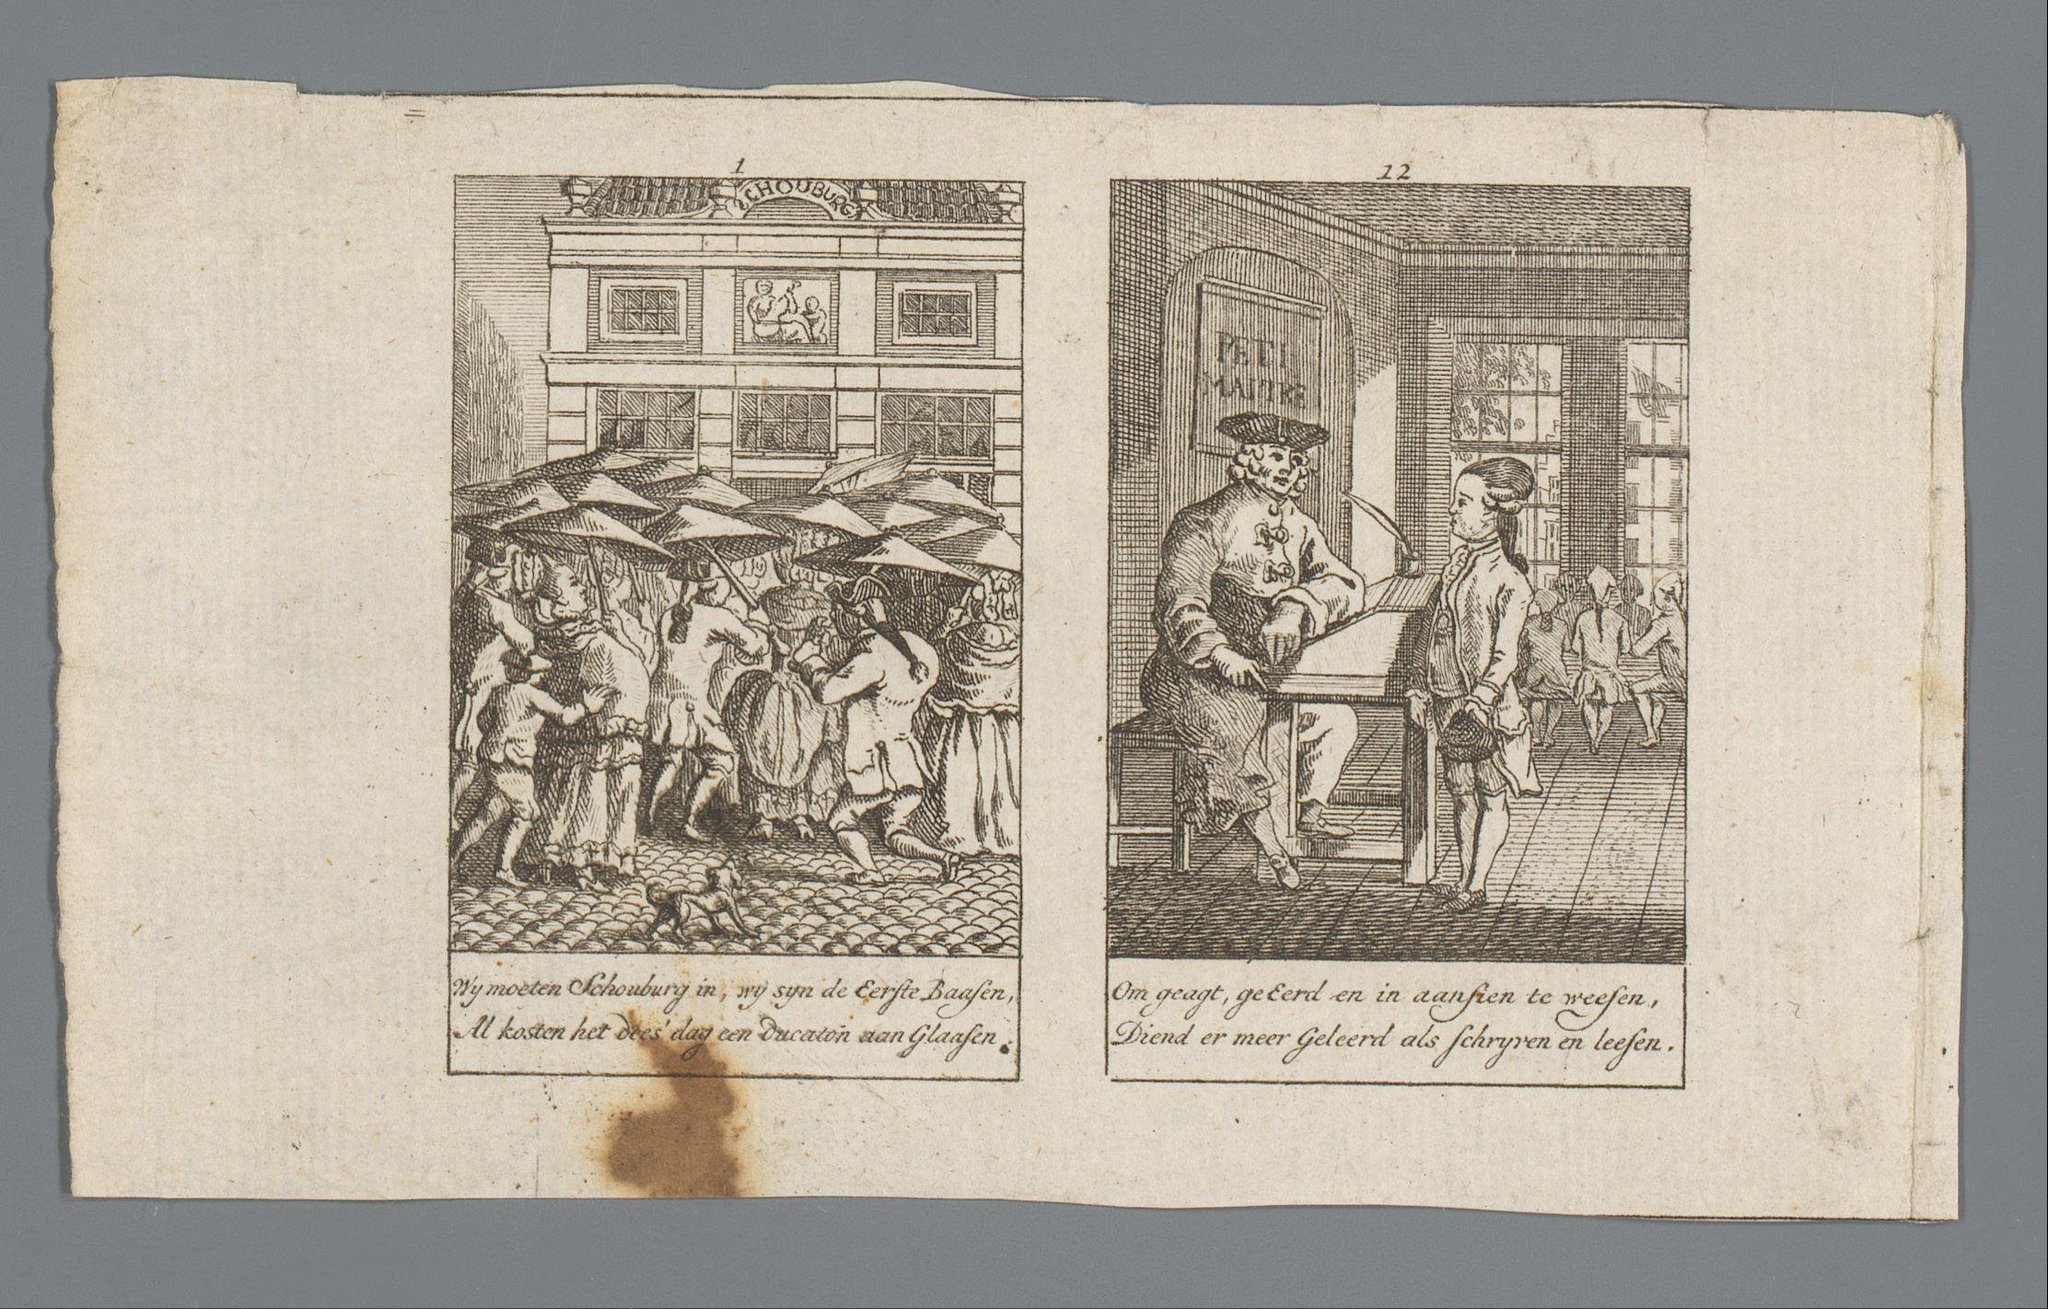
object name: print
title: Spotprenten op de moderne tijd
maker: Anonymous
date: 1750-1800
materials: paper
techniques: etching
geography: northern netherlands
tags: writing-table, writing-desk, dandy, beau, theatre (building), parasol, sunshade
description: Onversneden blad met twee voorstellingen, genummerd 1 en 12. Onder de voorstellingen twee versregels in het Nederlands. Links verdringen mensen zich voor de schouwburg, met het vers: 'Wij moeten Schouburg in, wij sijn de Eerste Baasen,/ Al kosten het dees' dag een Ducaton aan Glaazen'. Rechts staat een jongeman in een lokaal bij een man die achter een bureau zit. Achter deze man hangt een doek waarop staat 'Peti-Maitre'. Onder de voorstelling het vers: 'Om geagt, geeerd en in aanzien te weezen,/ Diend er meer Geleerd als schrijven en leezen'.